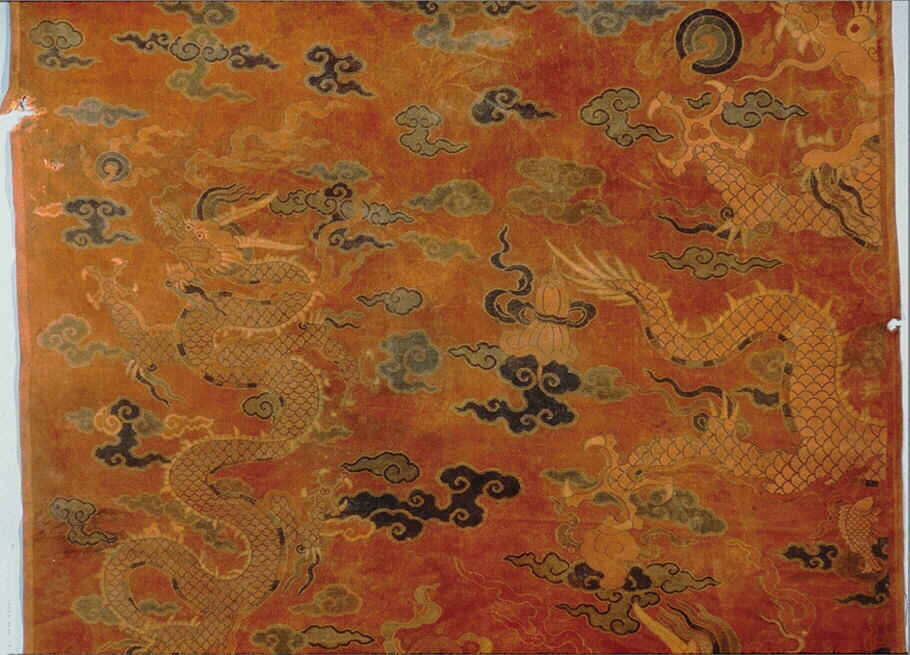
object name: breadth of woven textile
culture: chinese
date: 1701-1733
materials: gold, textile, silk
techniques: brocade, damask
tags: dragons